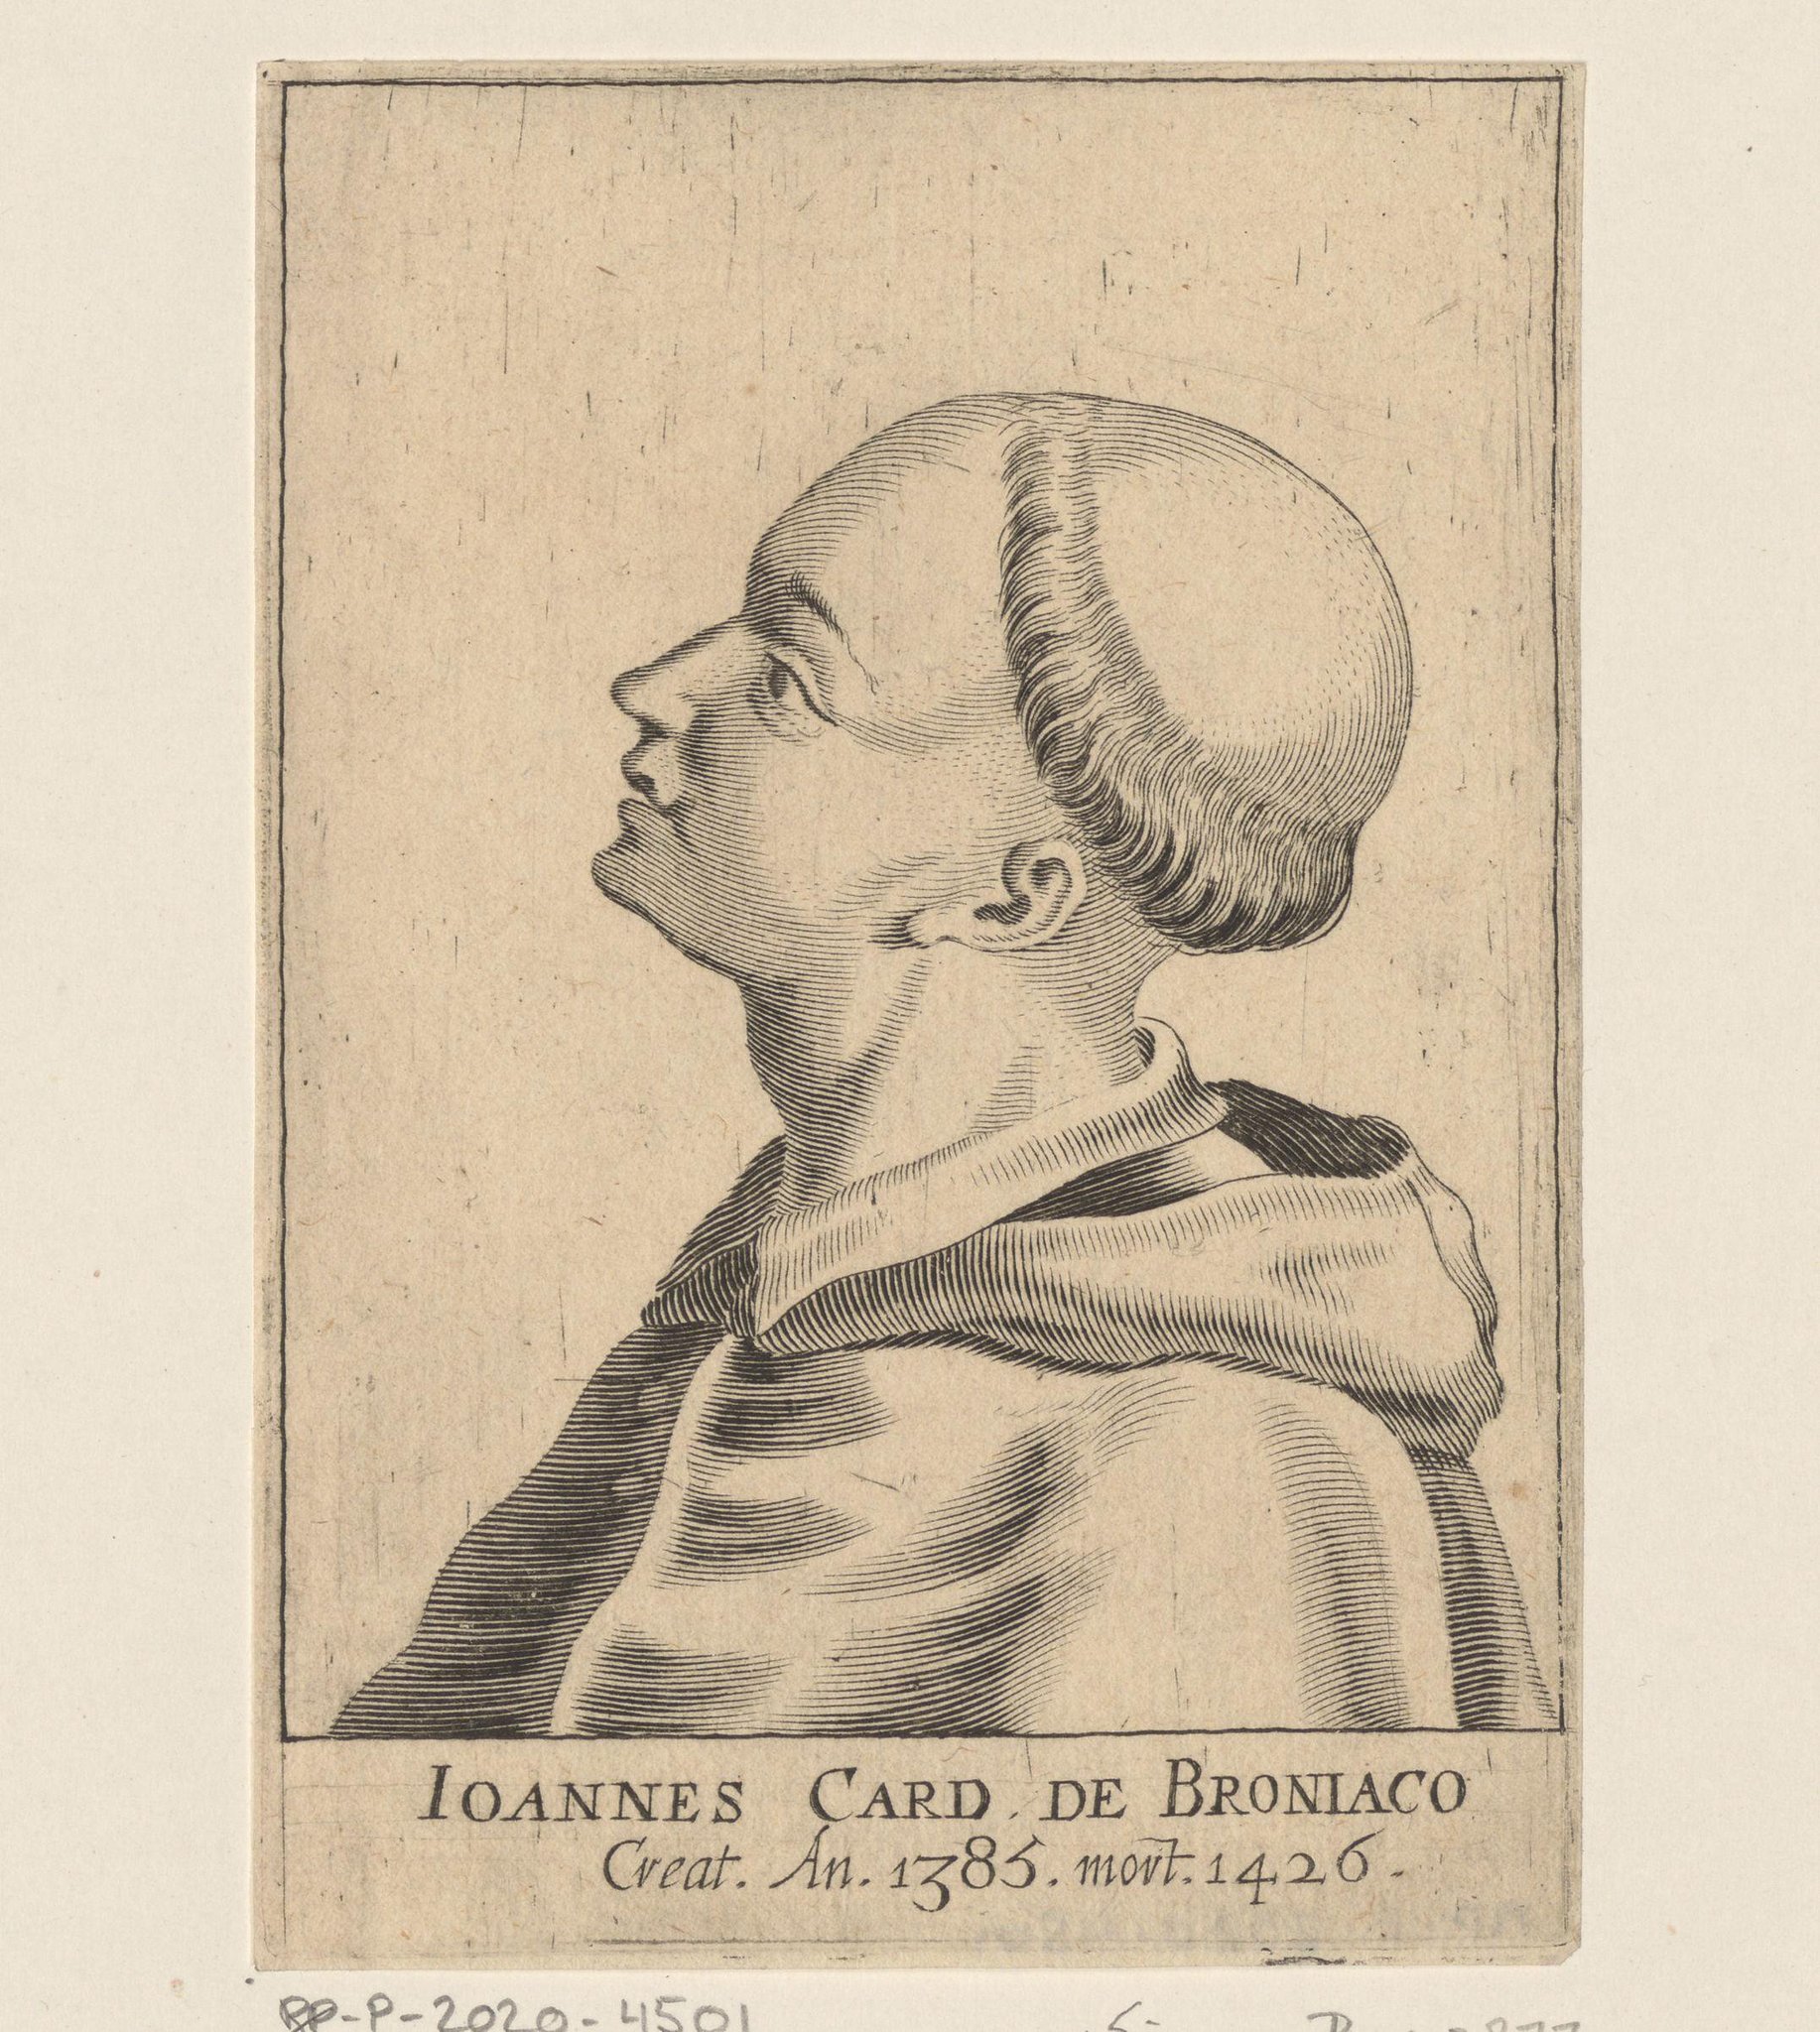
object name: print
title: Portret van Jean-Allarmet de Brogny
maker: Anonymous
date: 1600-1649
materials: paper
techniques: engraving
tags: cardinal, historical persons